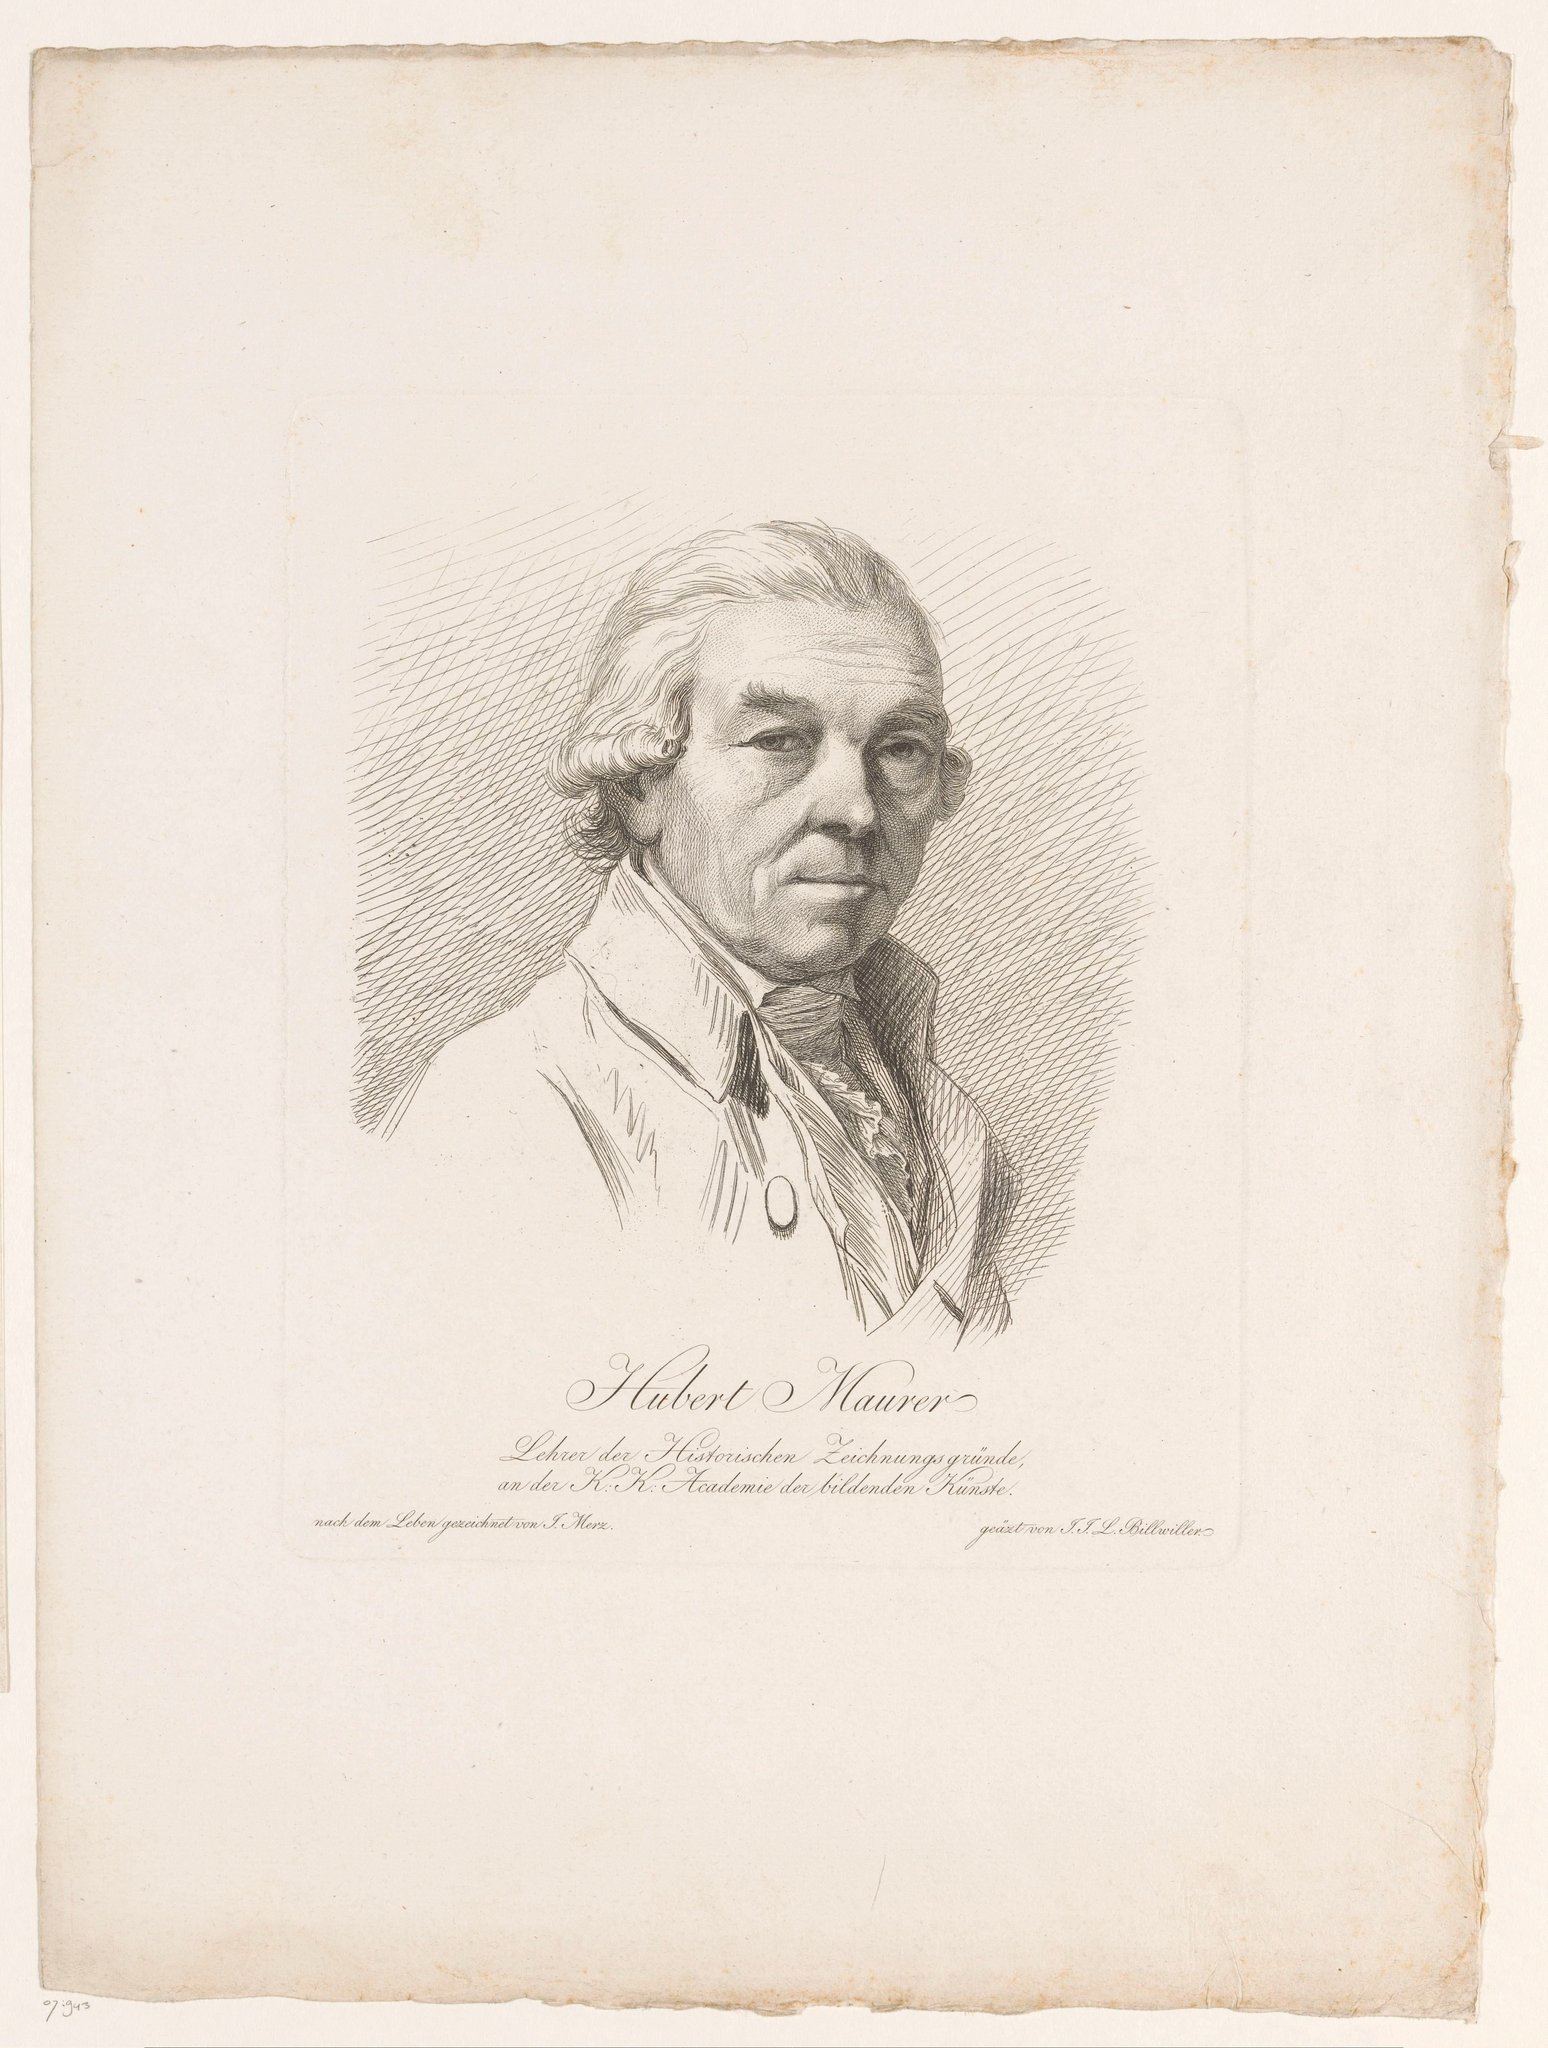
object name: print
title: Portret van Hubert Maurer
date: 1805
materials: paper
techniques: etching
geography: vienna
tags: vienna, painter, hubert maurer, portrait, self-portrait of artist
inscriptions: collector's mark: Lugt 2228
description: De prent maakt onderdeel uit van een serie van zes portretten van docenten werkzaam aan de Akademie der bildenden Künste te Wenen.